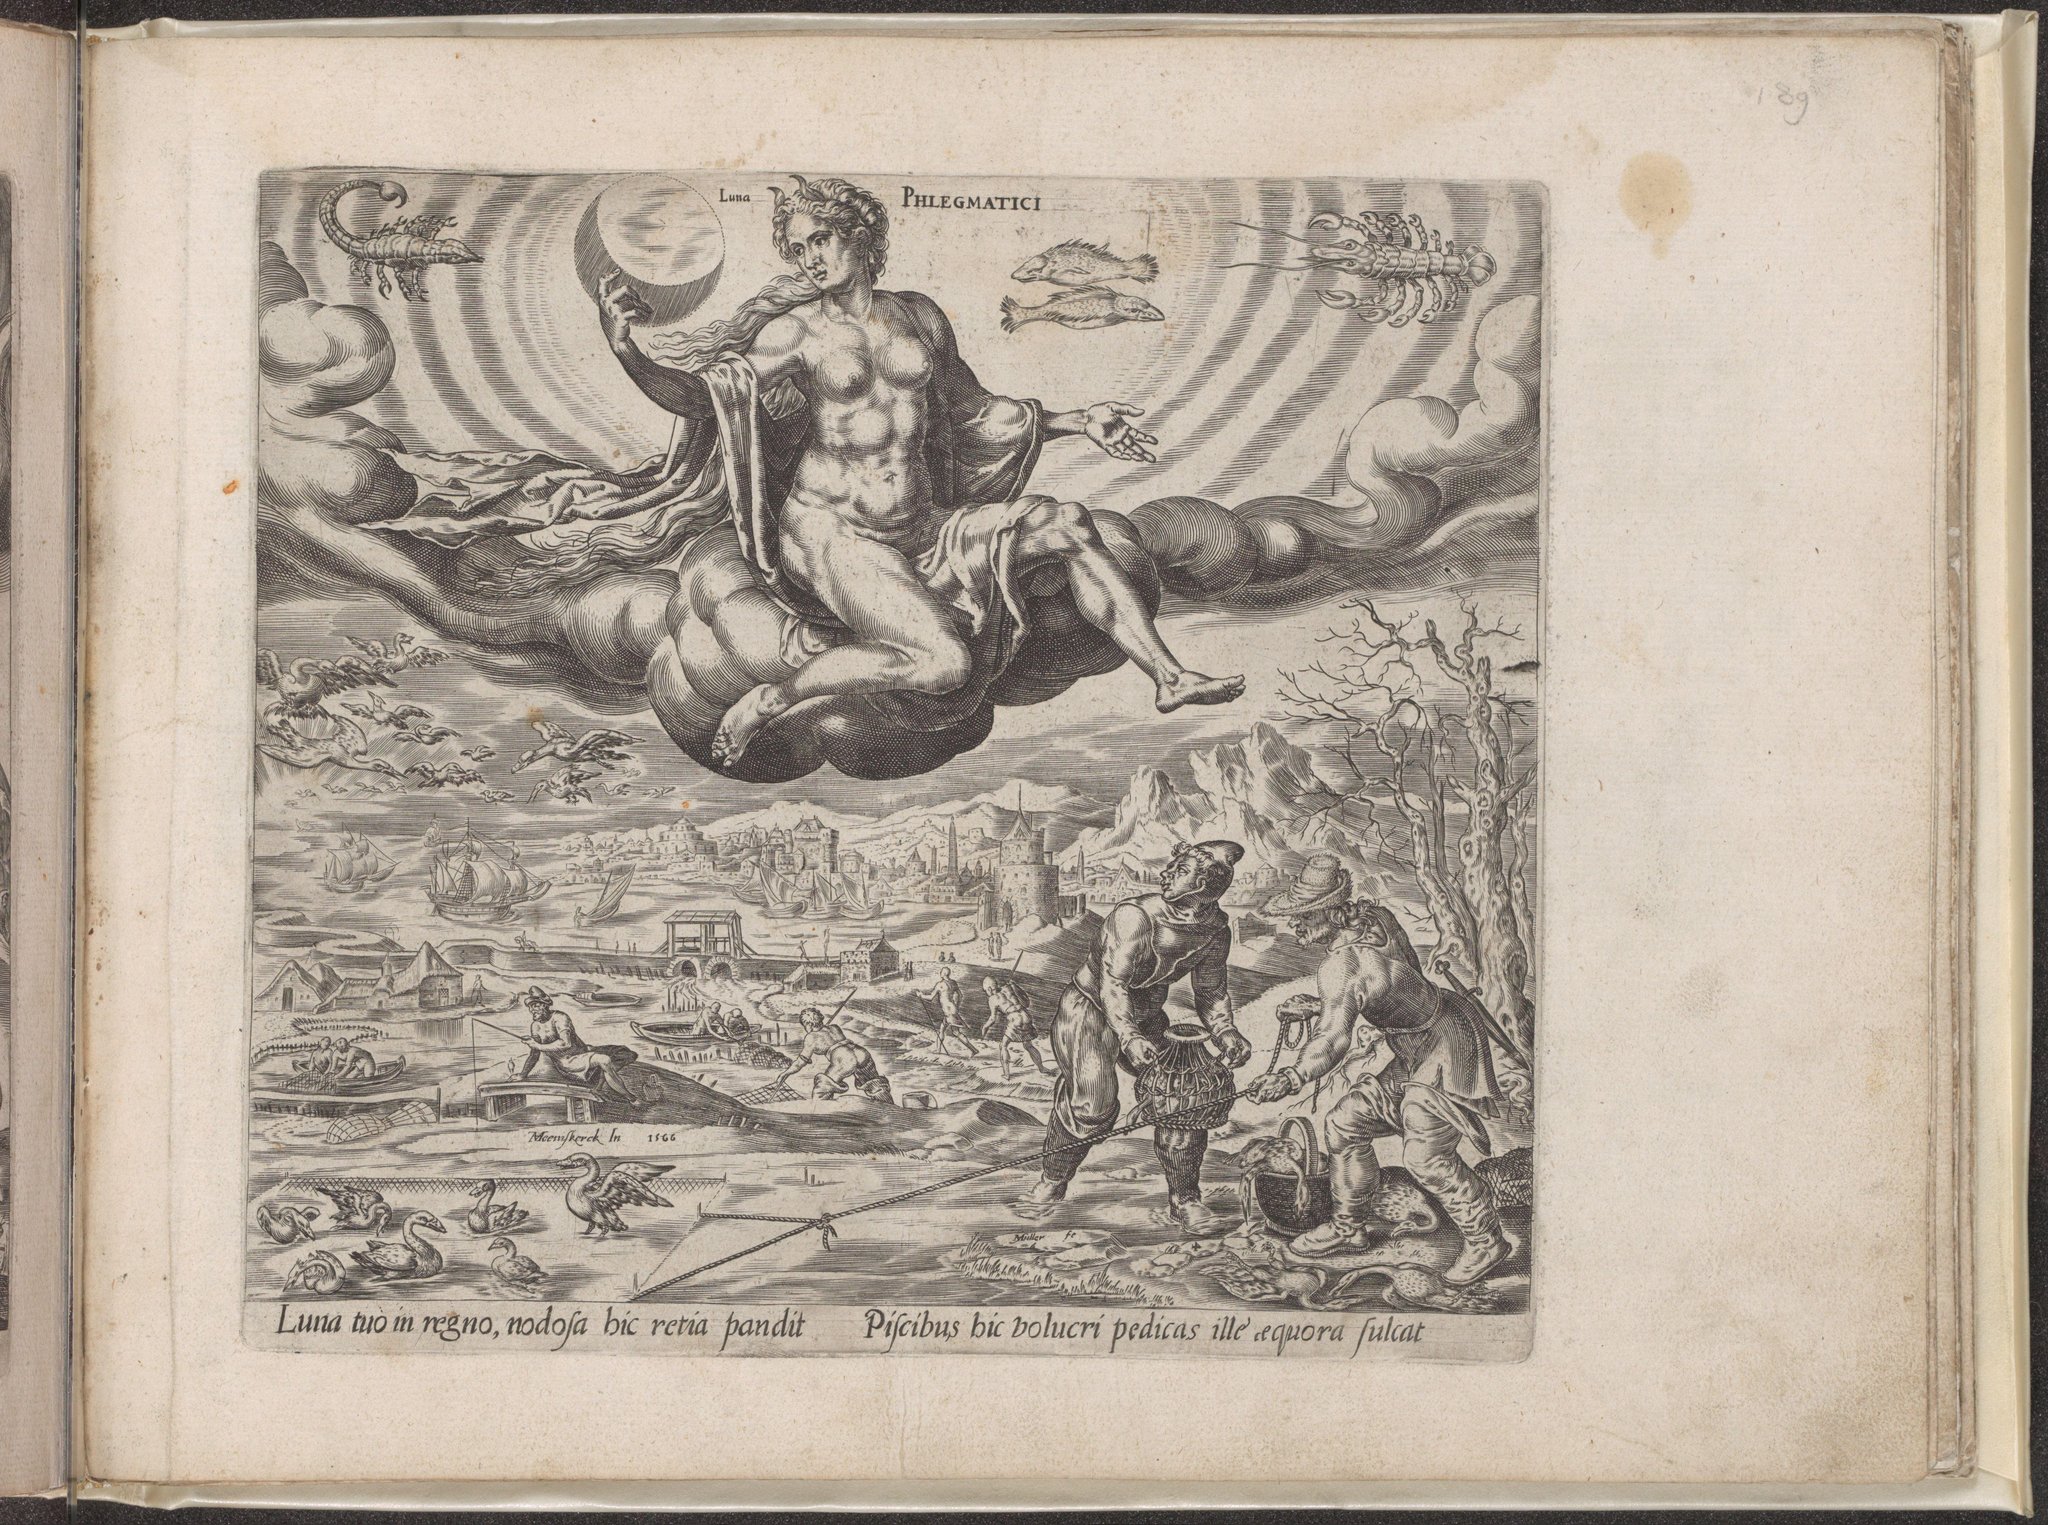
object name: print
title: De vier temperamenten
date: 1566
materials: paper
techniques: engraving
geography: haarlem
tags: fresh-water fishery, diana as moon-goddess, i.e. luna (selene), ships (in general), bird hunting, phlegmatic temperament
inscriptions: date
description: Luna, de maan, zit op een wolk en houdt de maansikkel in haar hand. Boven haar staan drie tekens van de zodiak: Schorpioen, Vissen en Kreeft, die passen bij het element water. Onder haar, op aarde, de mensen met een flegmatisch temperament, die door haar geregeerd worden. Rechts staan eendenjagers en op de achtergrond zijn vissers en zeelieden aan het werk. Onderaan in de marge een tekst in het Latijn over de flegmatici en Luna. Deze prent maakt deel uit van een album.